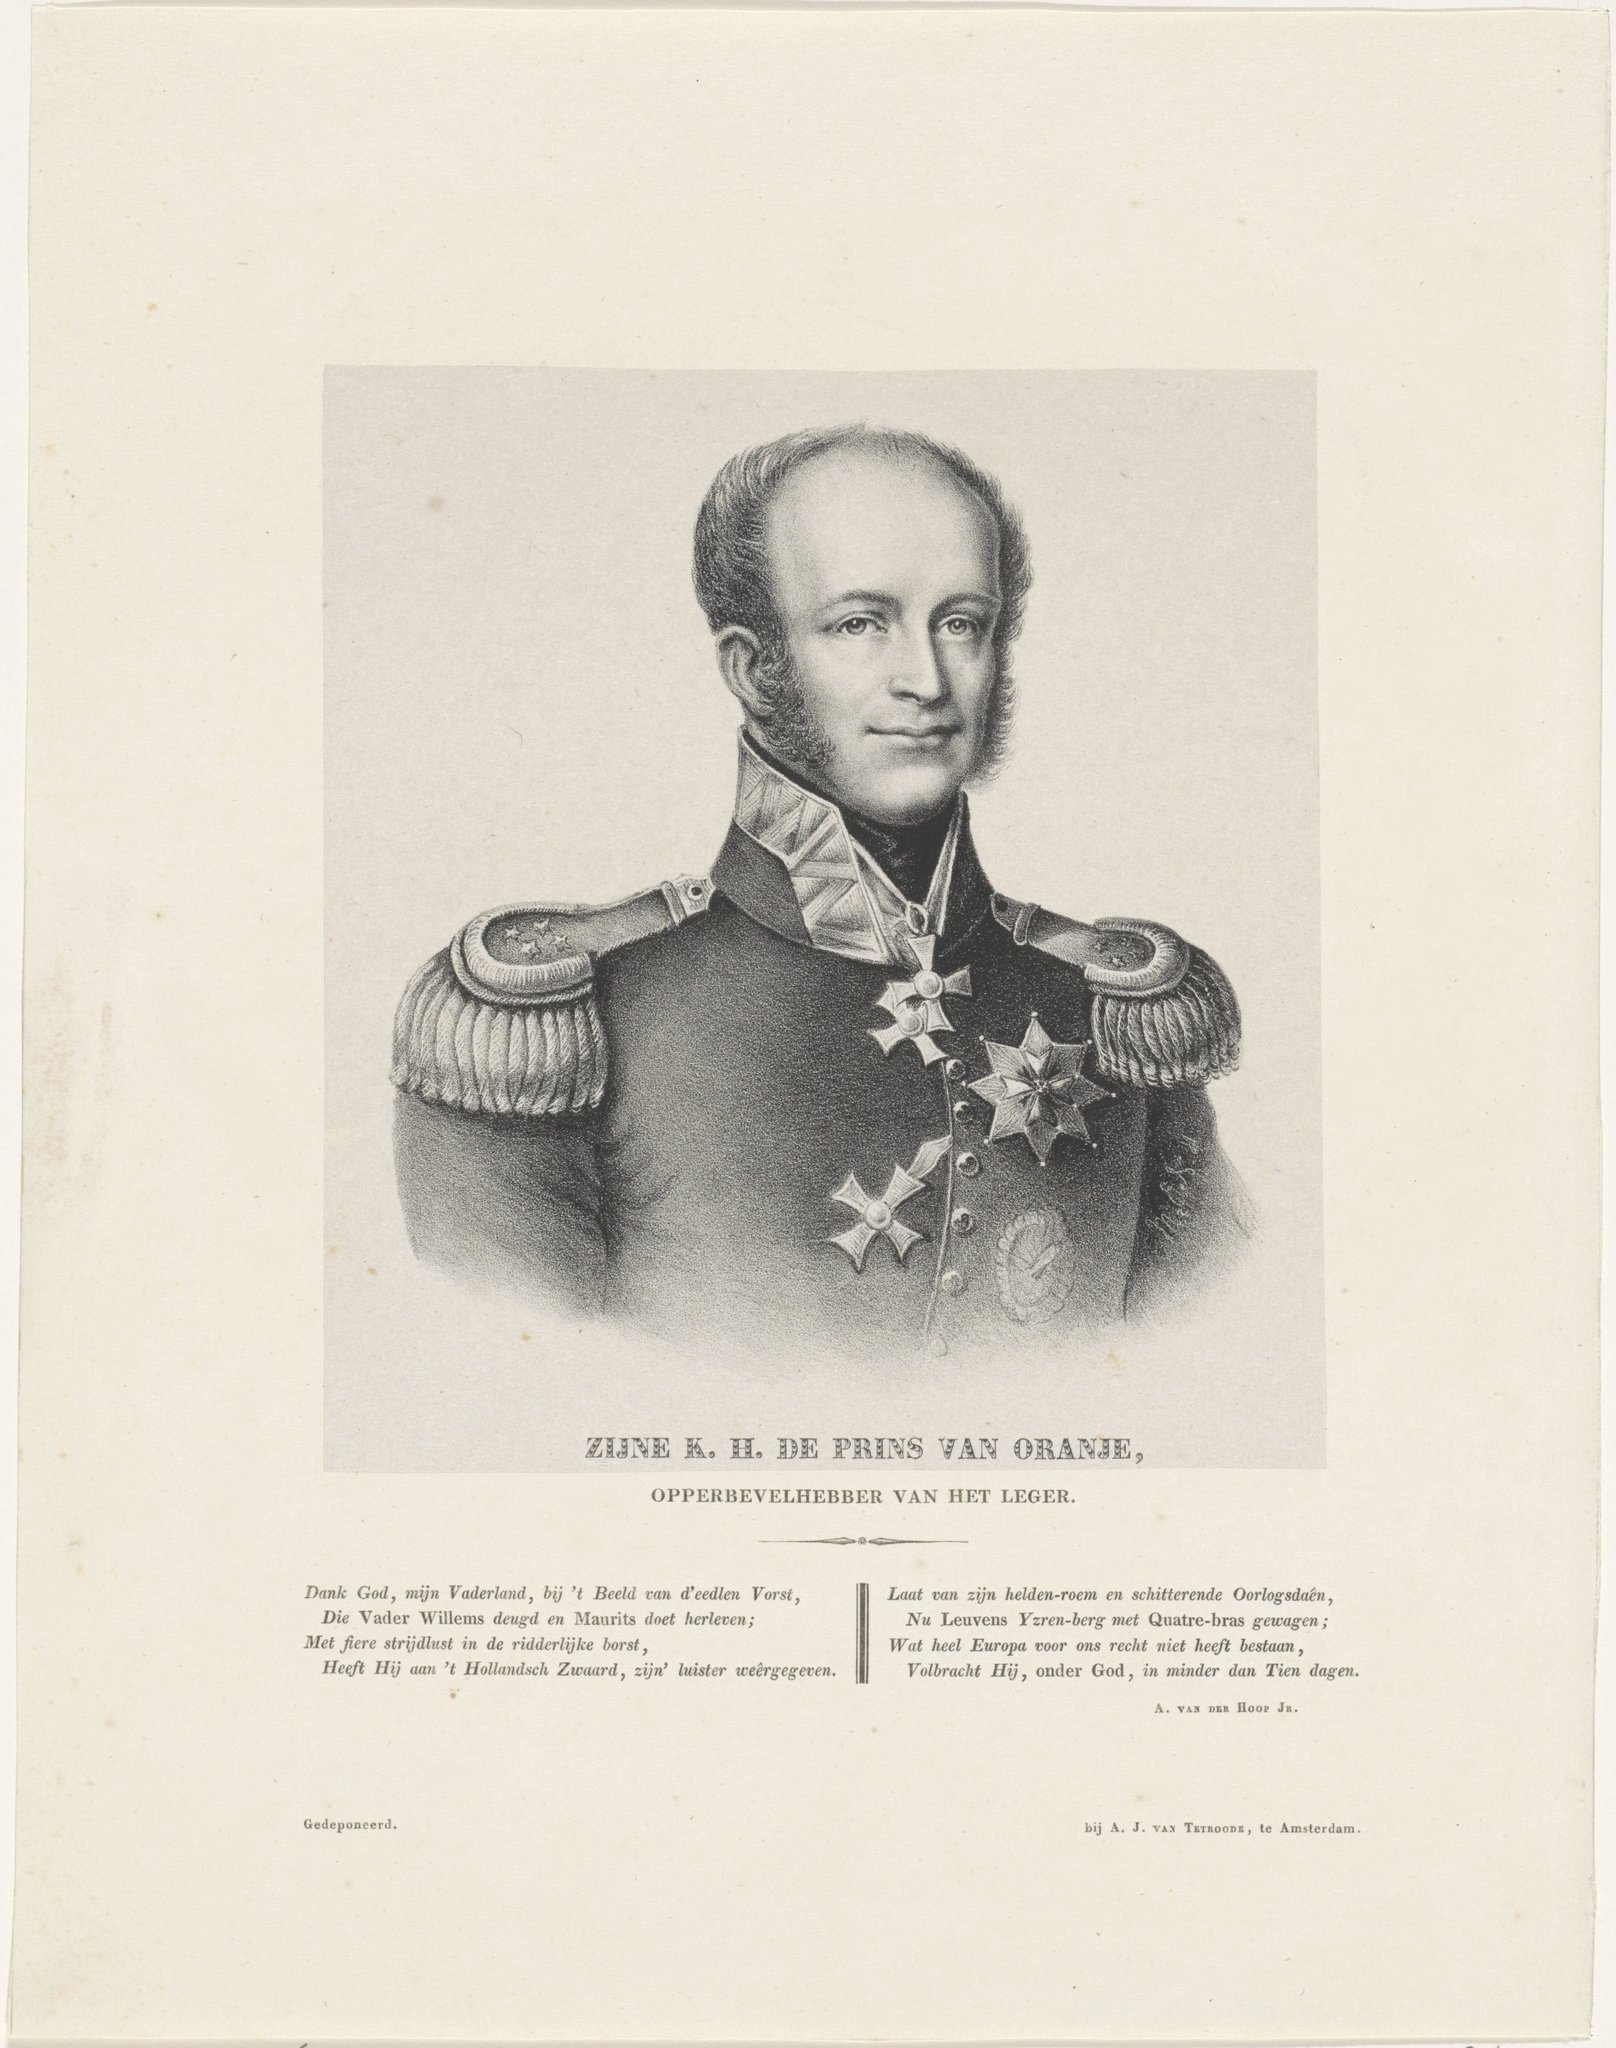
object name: print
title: Portret van Willem II, koning der Nederlanden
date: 1831-1833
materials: paper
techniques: letterpress printing, lithograph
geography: netherlands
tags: the hague, william ii of the netherlands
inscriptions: collector's mark: Lugt 2228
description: Portret van Willem II. In de ondermarge zijn titel. Daaronder zijn titel en twee kolommen met elk vier regels Nederlandse tekst in boekdruk over de Tiendaagse Veldtocht, van 2 tot 12 augustus 1831.